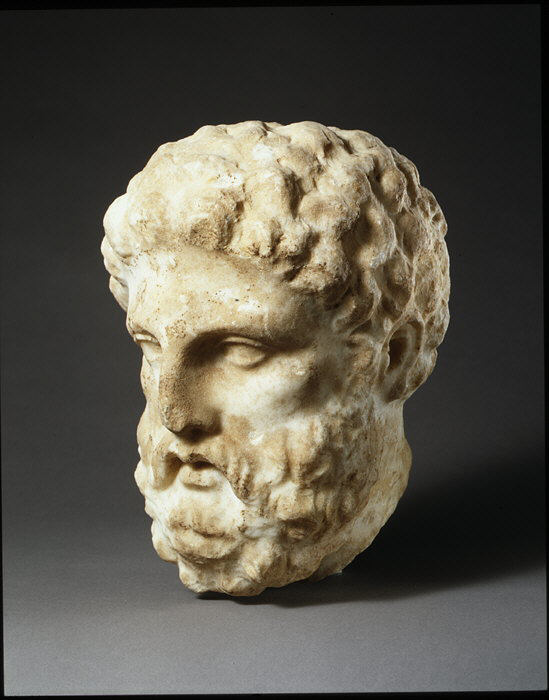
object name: head of a man from a grave stele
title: Marble head of a man from a grave stele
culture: greek, attic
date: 325 BCE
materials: marble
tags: heads,men